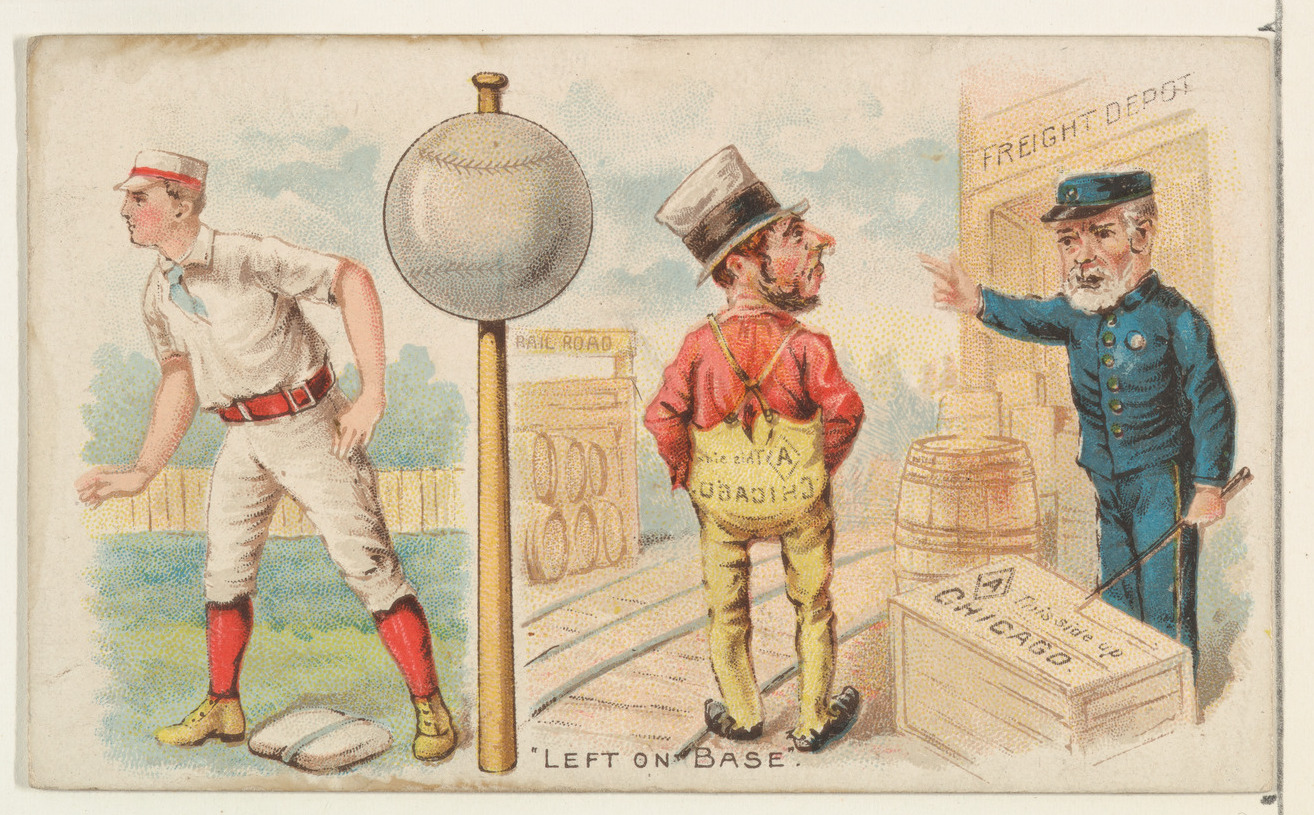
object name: print, baseball card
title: Left on Base, from the Talk of the Diamond set (N135) issued by Duke Sons & Co., a branch of the American Tobacco Company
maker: w. duke, sons & co.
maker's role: publisher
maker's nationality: american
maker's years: 1870-1920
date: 1888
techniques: color lithograph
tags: men